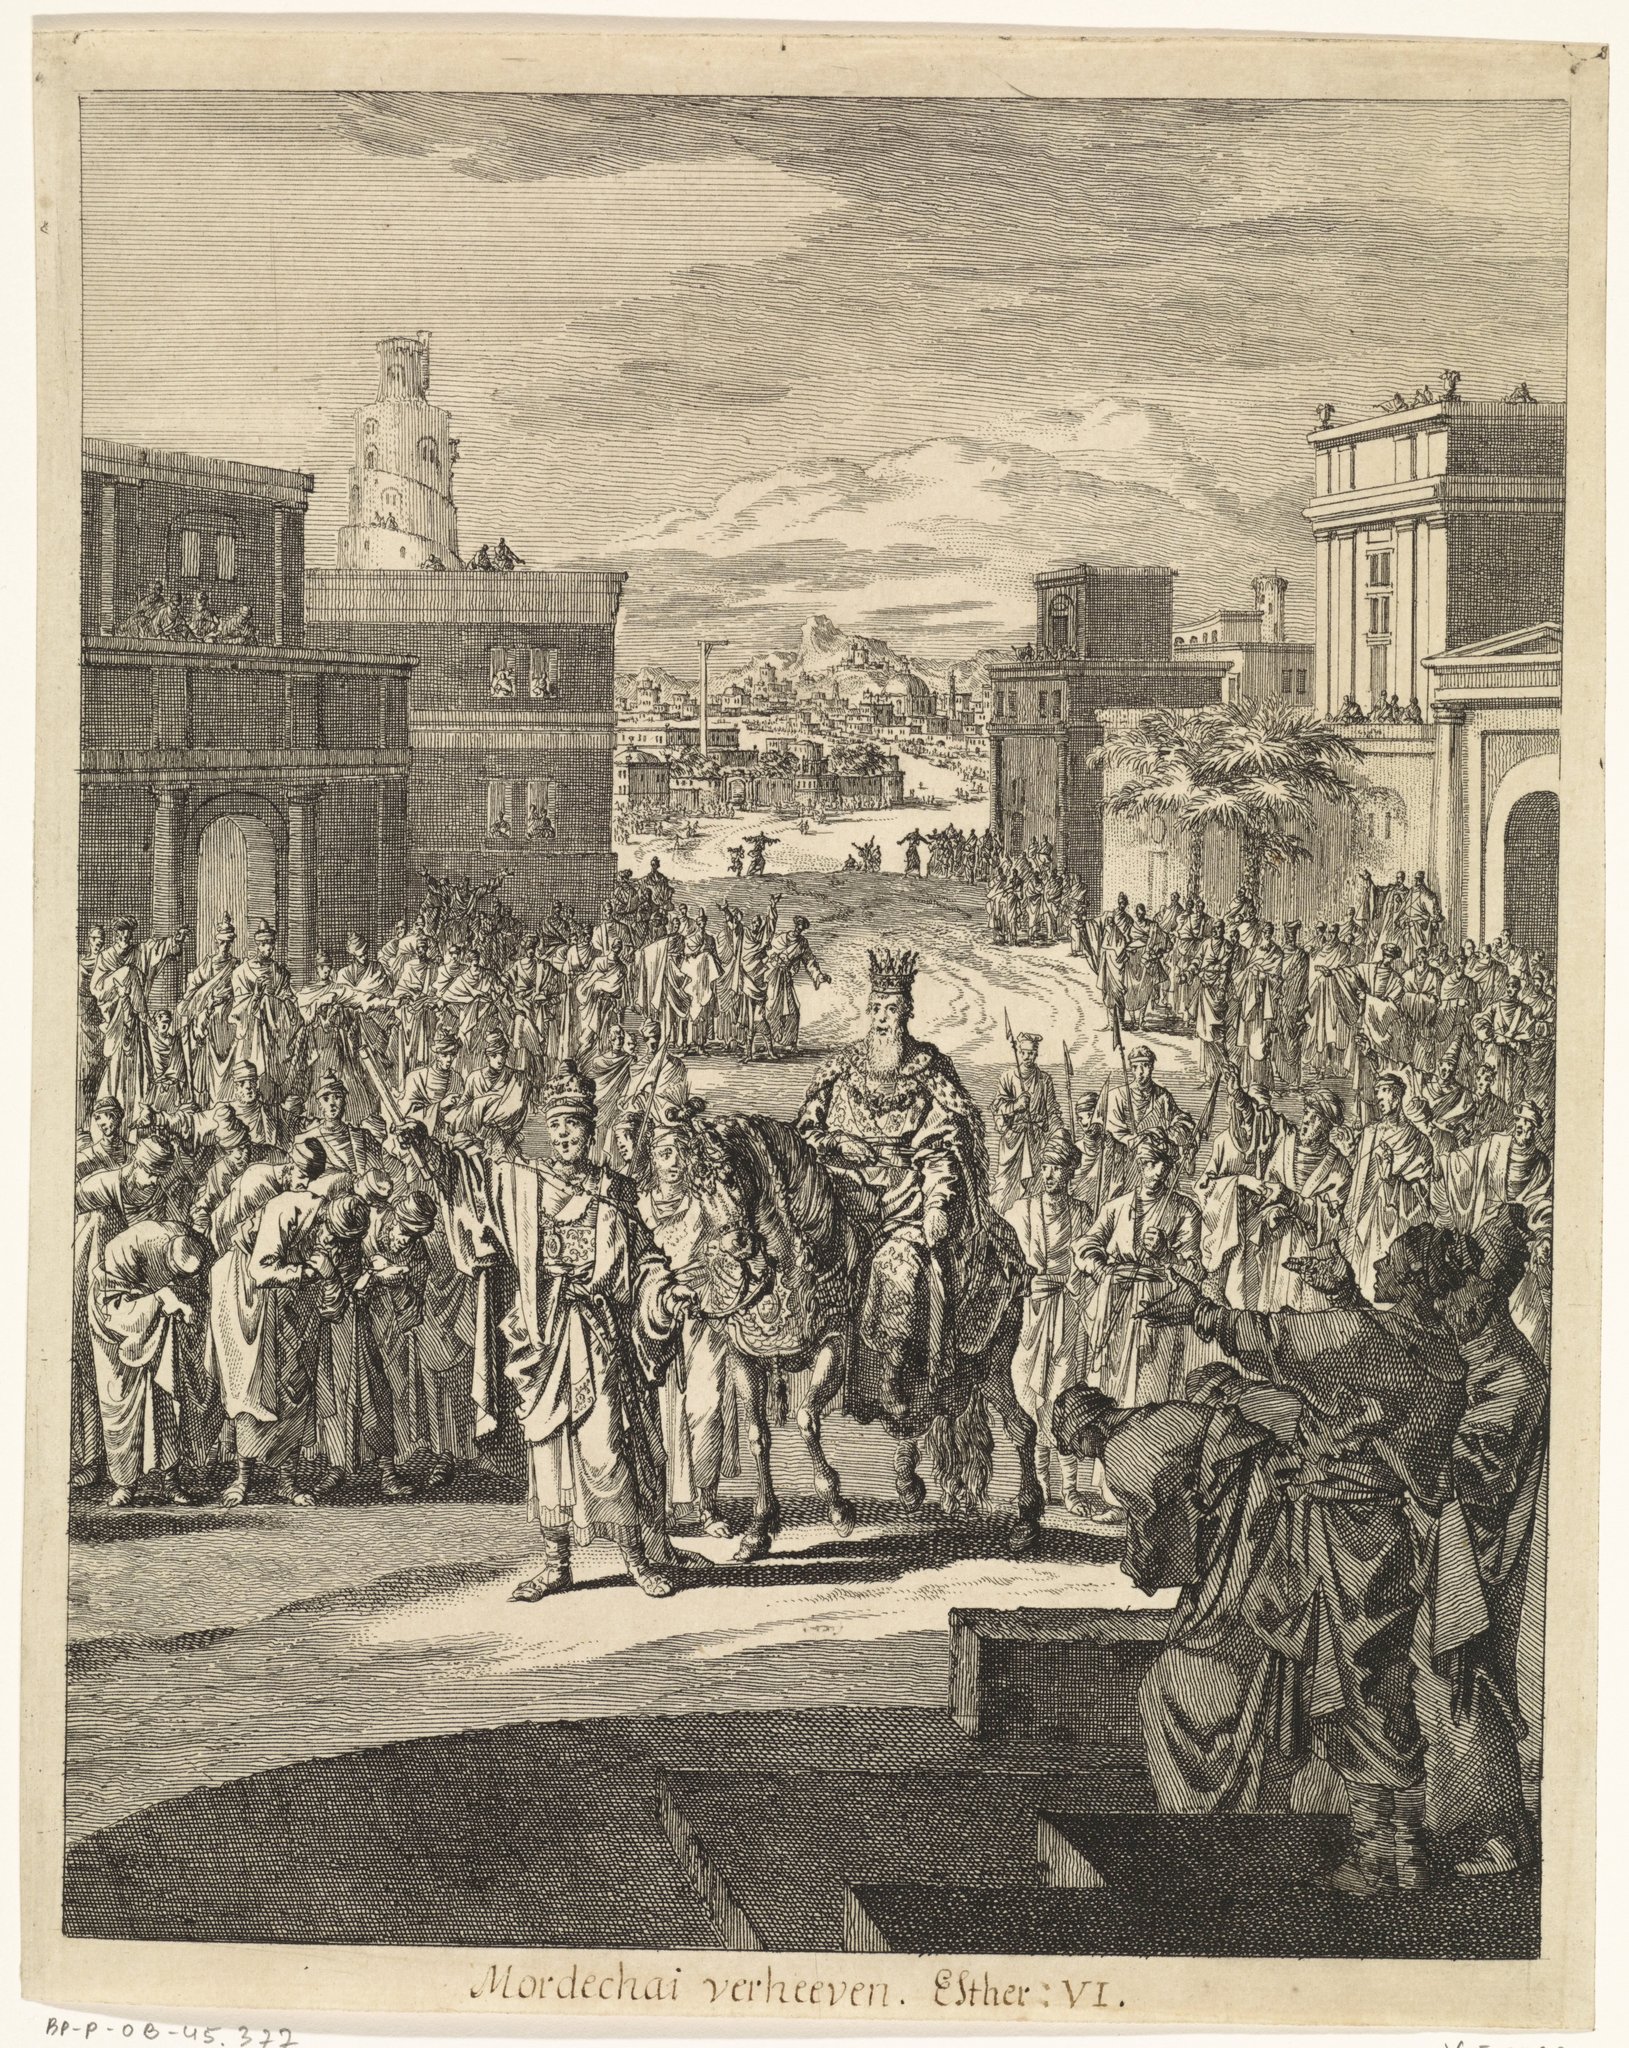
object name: print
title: Triomf van Mordechai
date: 1708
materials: paper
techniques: etching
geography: amsterdam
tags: mordecai's triumph: mordecai, mounted on the king's horse, is led through the city by haman (esther and ahasuerus may be looking on from the palace)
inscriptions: collector's mark: Lugt 2228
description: Proefdruk van een prent welke is opgenomen als illustratie in: Historiae Celebriores Veteris Testamenti. Christoph Weigel, 1708.